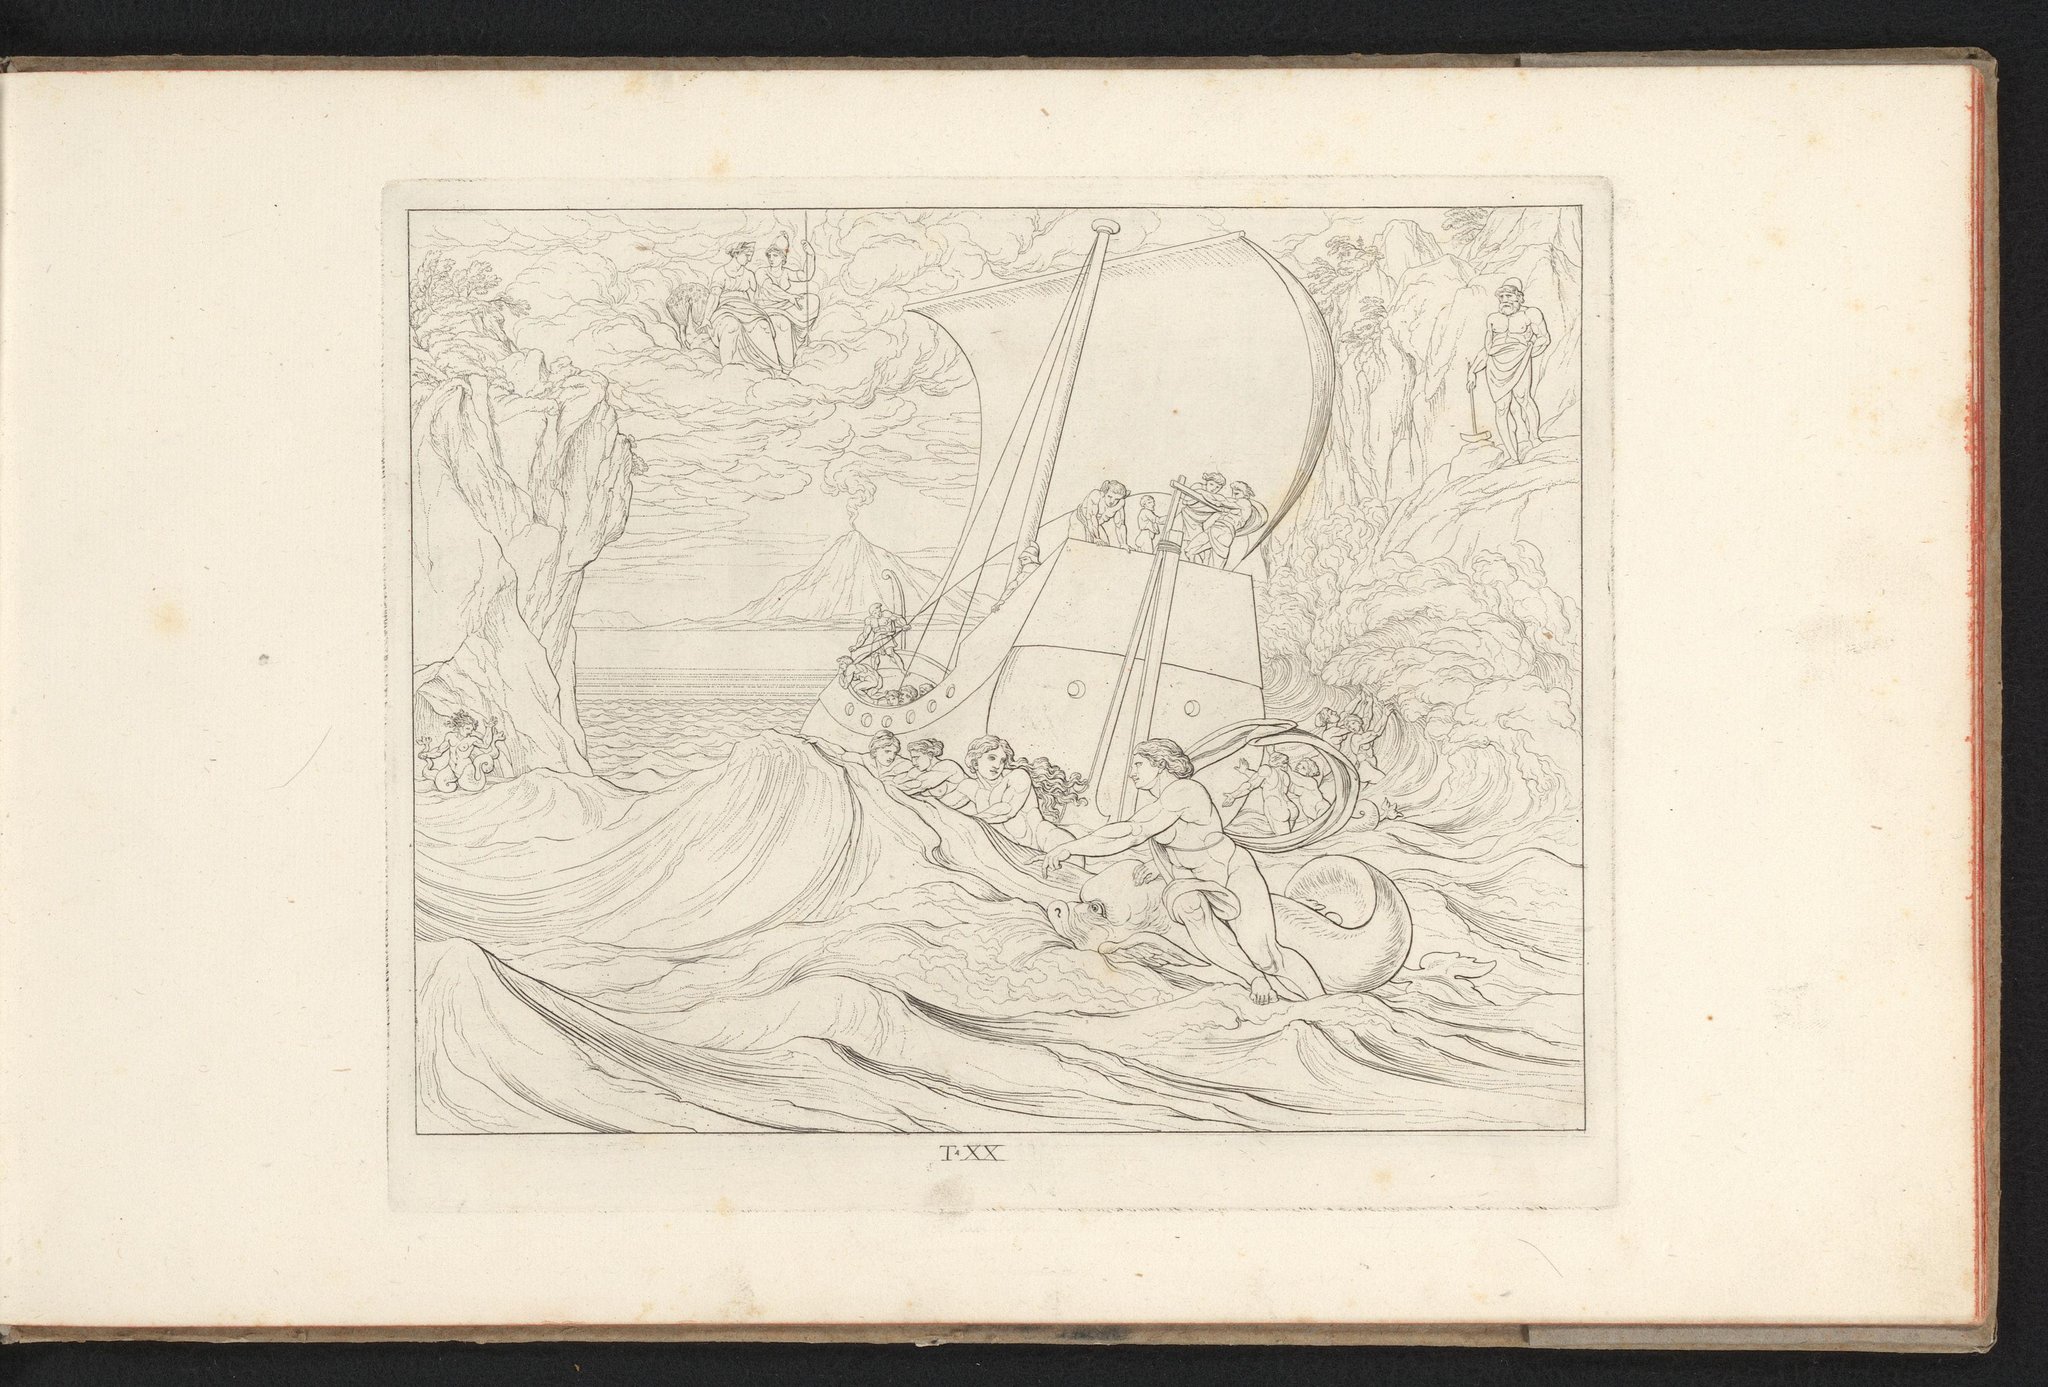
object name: print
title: Jason en de Argonauten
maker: joseph anton koch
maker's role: draughtsman, painter, print maker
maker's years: 1768-1839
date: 1799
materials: paper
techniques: etching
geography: rome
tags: scenes from the story of the argonauts that cannot be located in the chronological sequence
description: Deze prent maakt deel uit van een serie met 24 prenten.